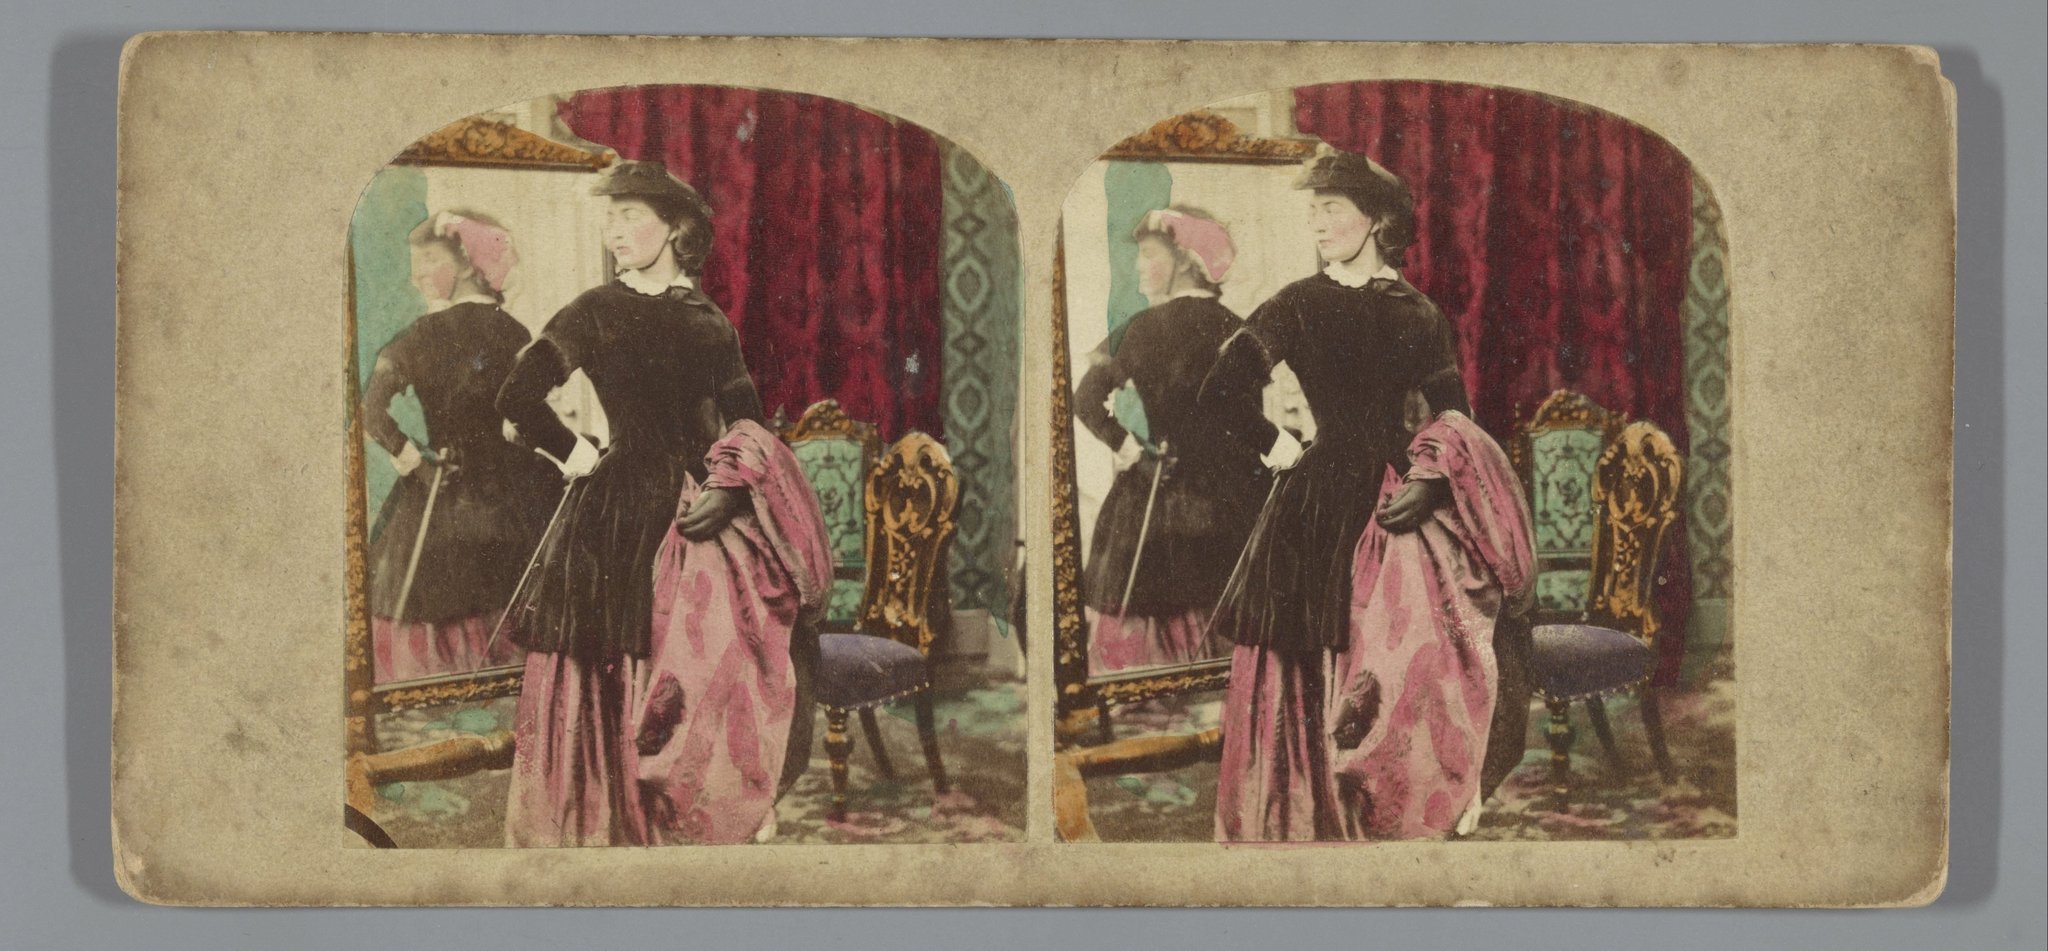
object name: stereograph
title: Vrouw gekleed in rijkostuum staat voor een spiegel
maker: Anonymous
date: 1852-1863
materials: cardboard, paper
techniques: albumen print, hand coloring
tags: mirror, interior of the house